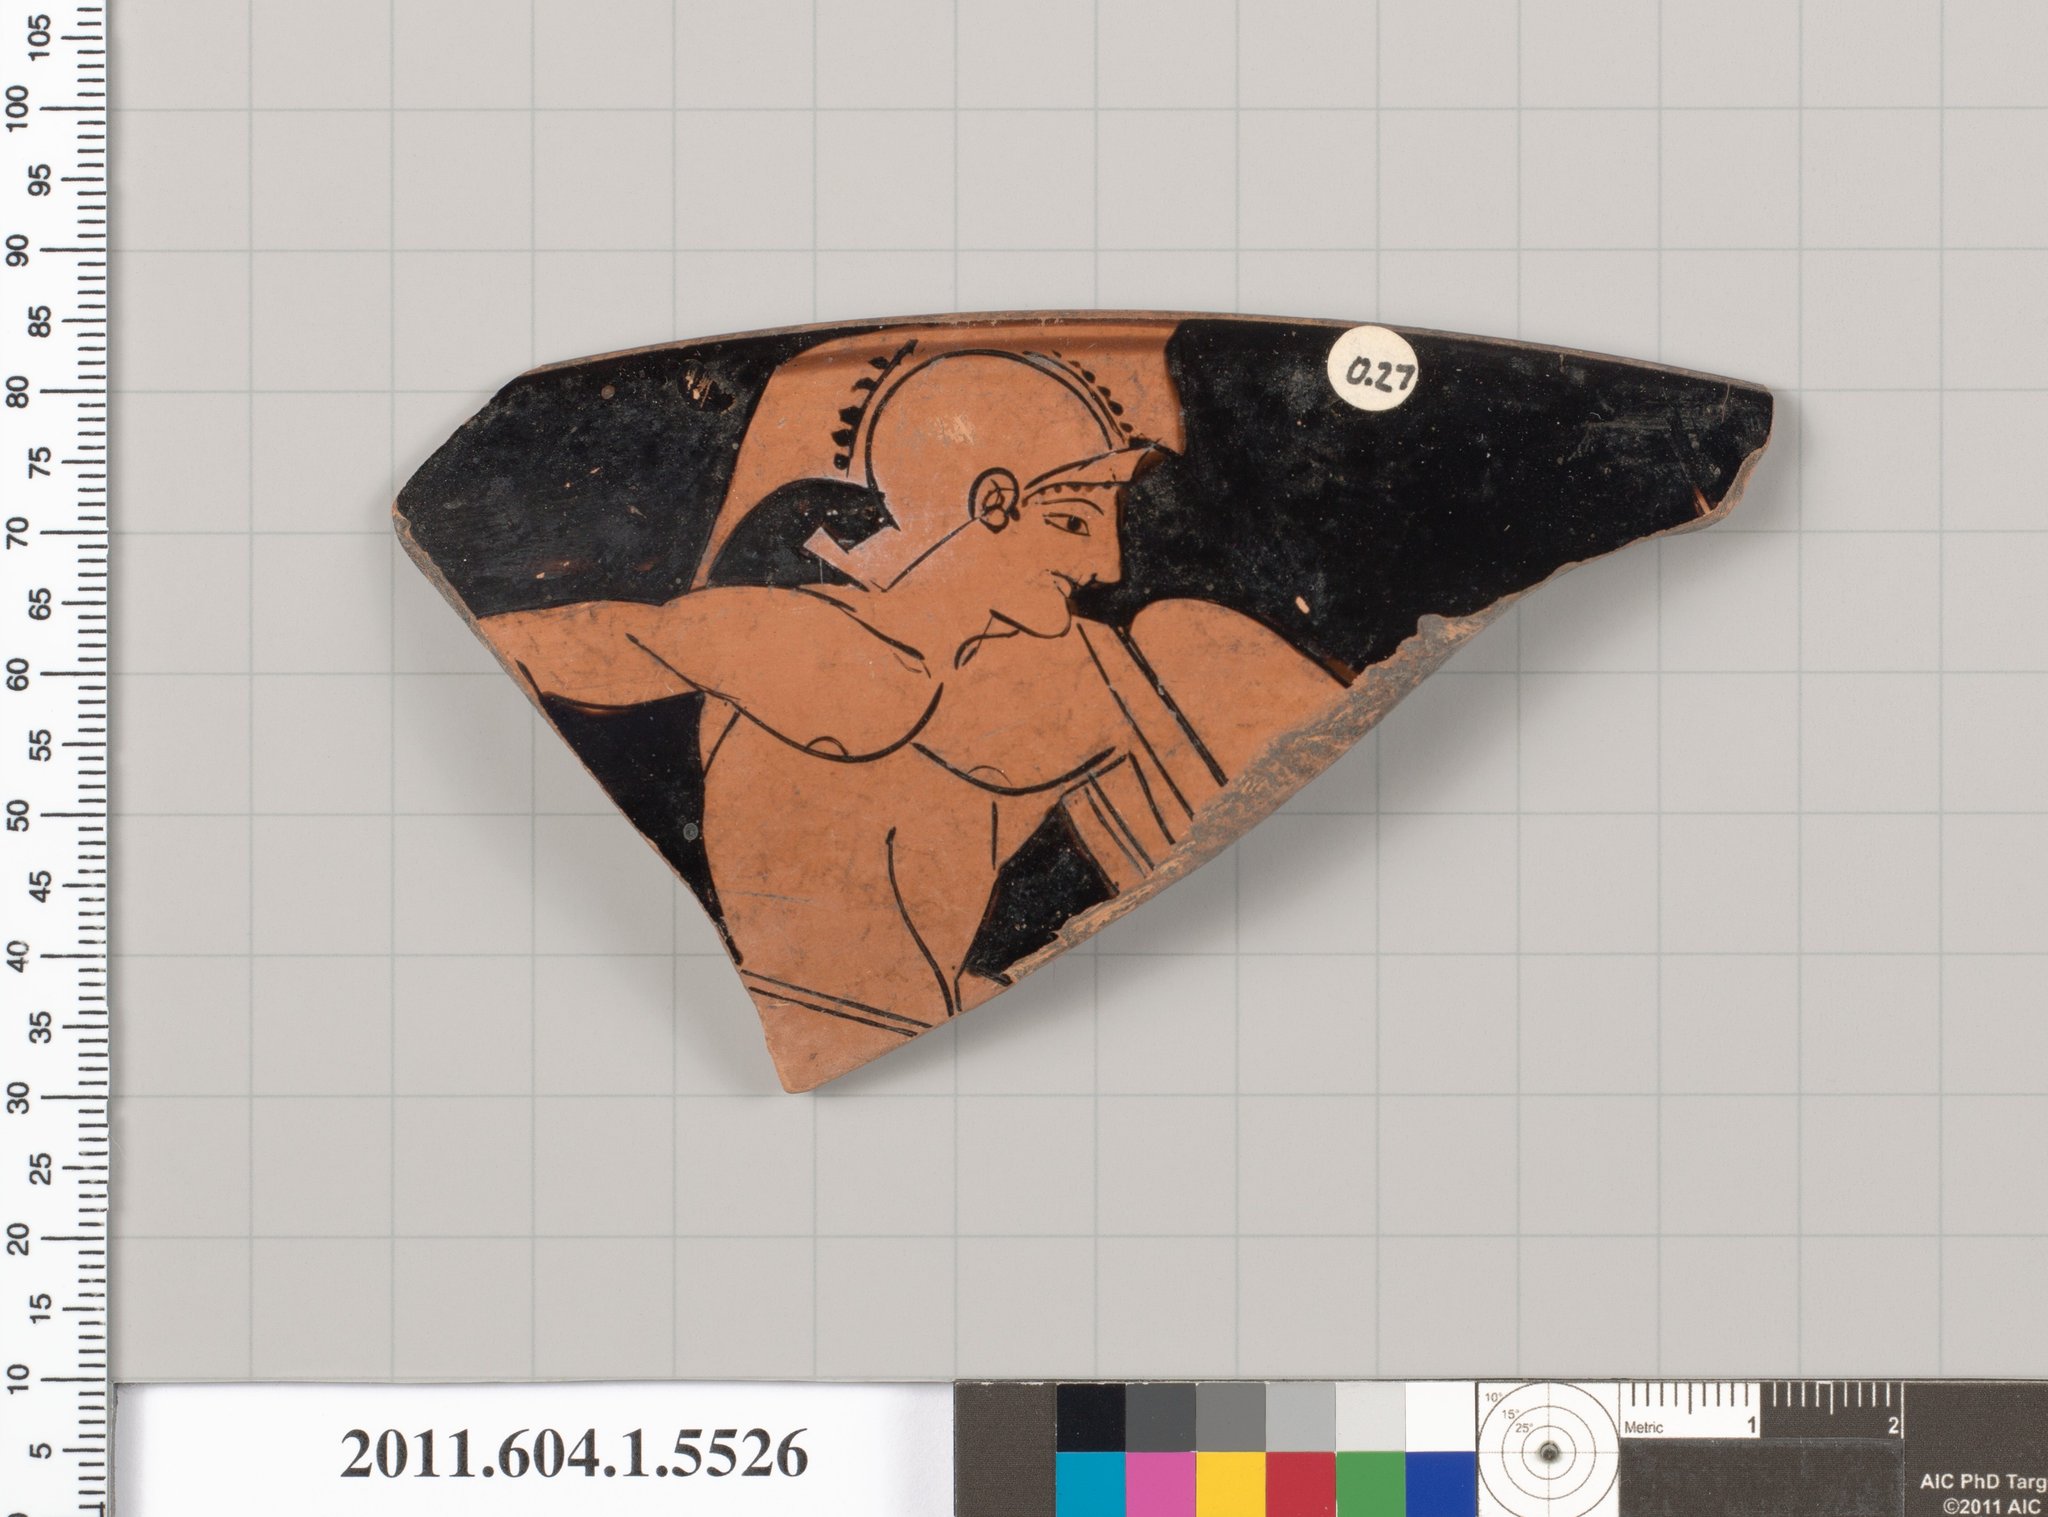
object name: kylix fragment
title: Terracotta rim fragment of a kylix (drinking cup)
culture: greek, attic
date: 520-510 BCE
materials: terracotta